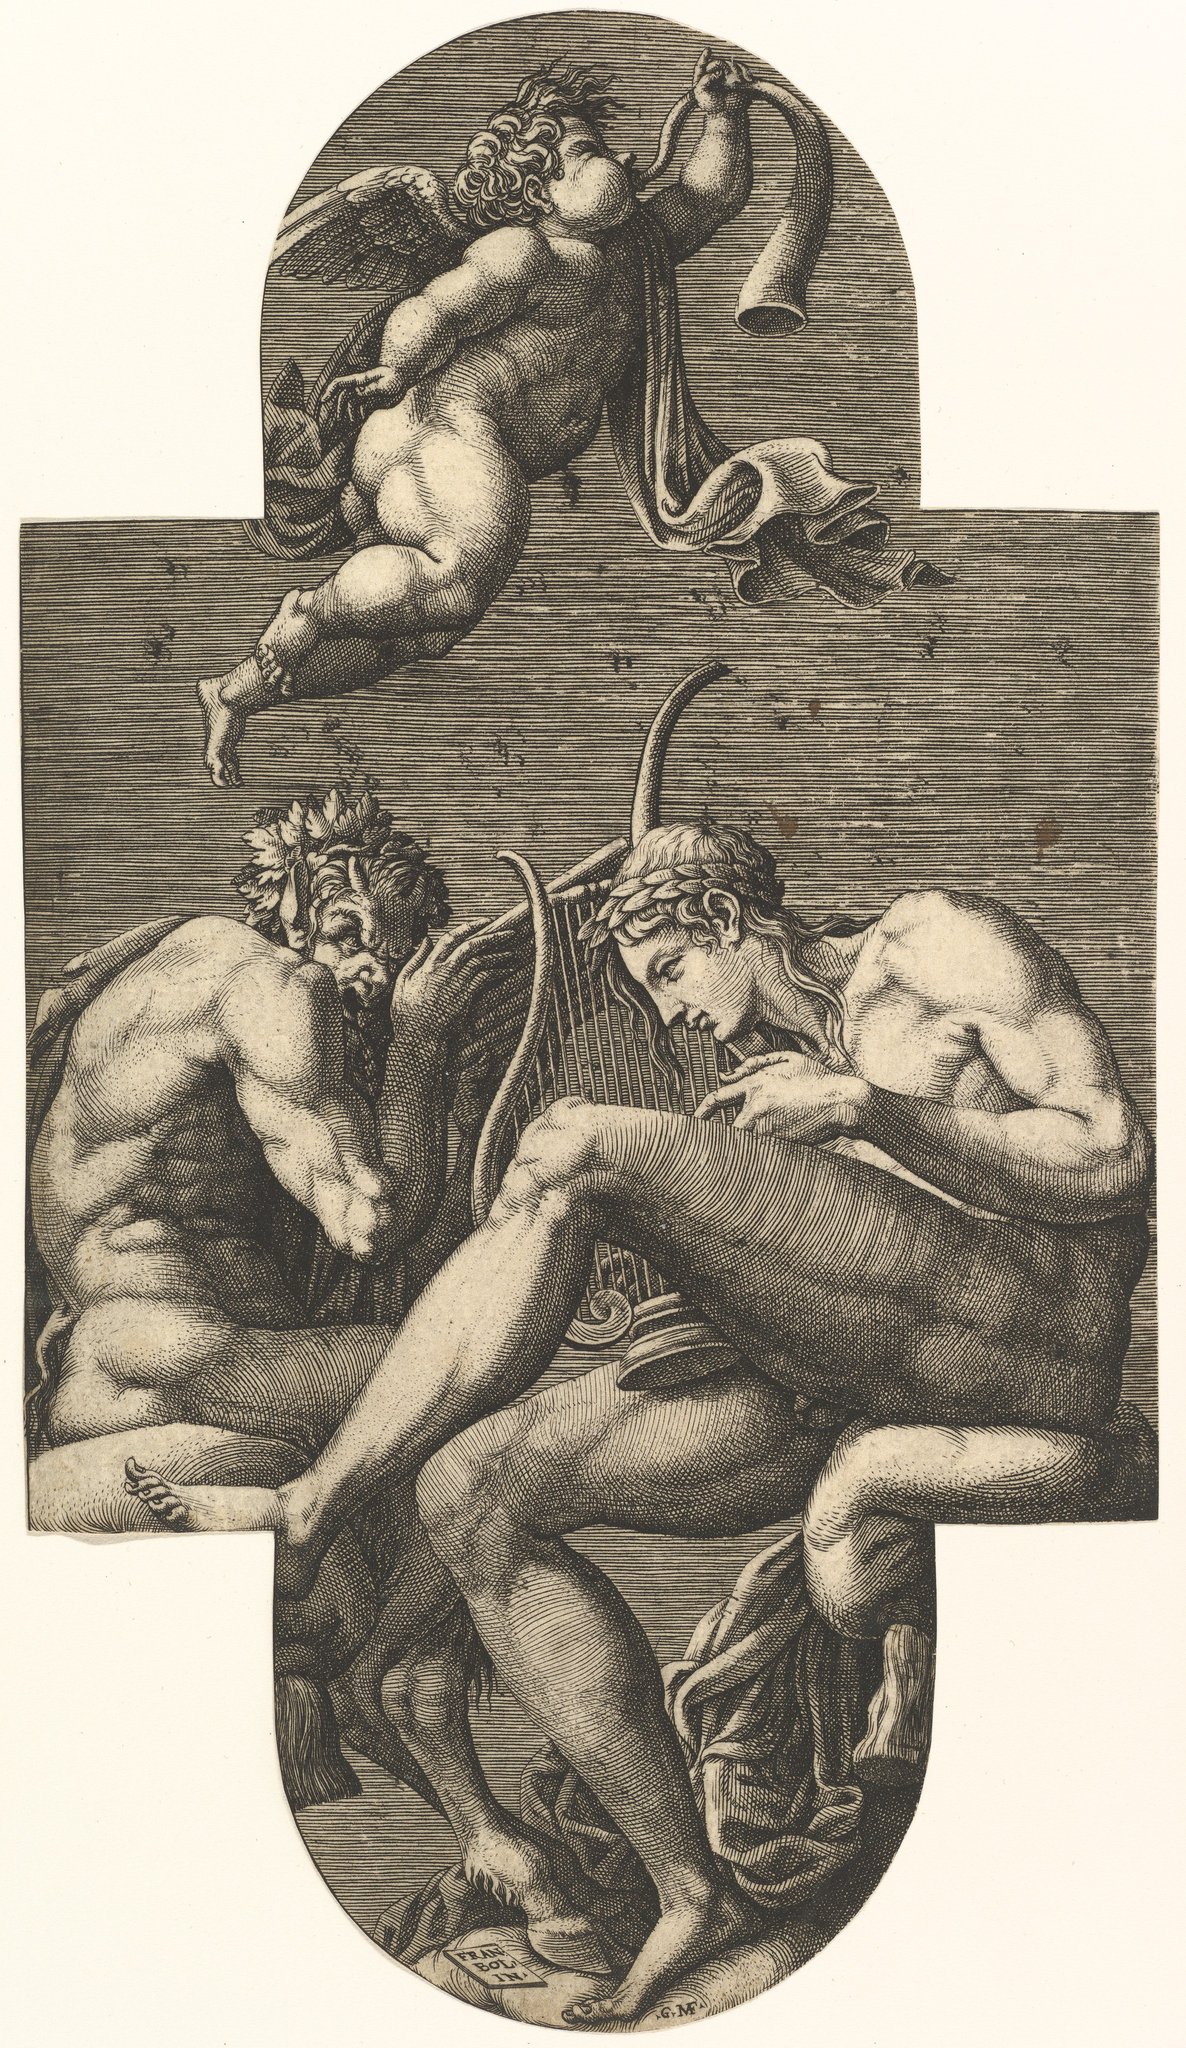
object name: print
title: Apollo, Pan, and a putto blowing a horn, from a series of eight compositions after Francesco Primaticcio's designs for the ceiling of the Ulysses Gallery (destroyed 1738-39) at Fontainebleau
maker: giorgio ghisi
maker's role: artist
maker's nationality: italian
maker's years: 1515-1582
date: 1560-1569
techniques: engraving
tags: male nudes,horns,apollo,putti,pan,lyres